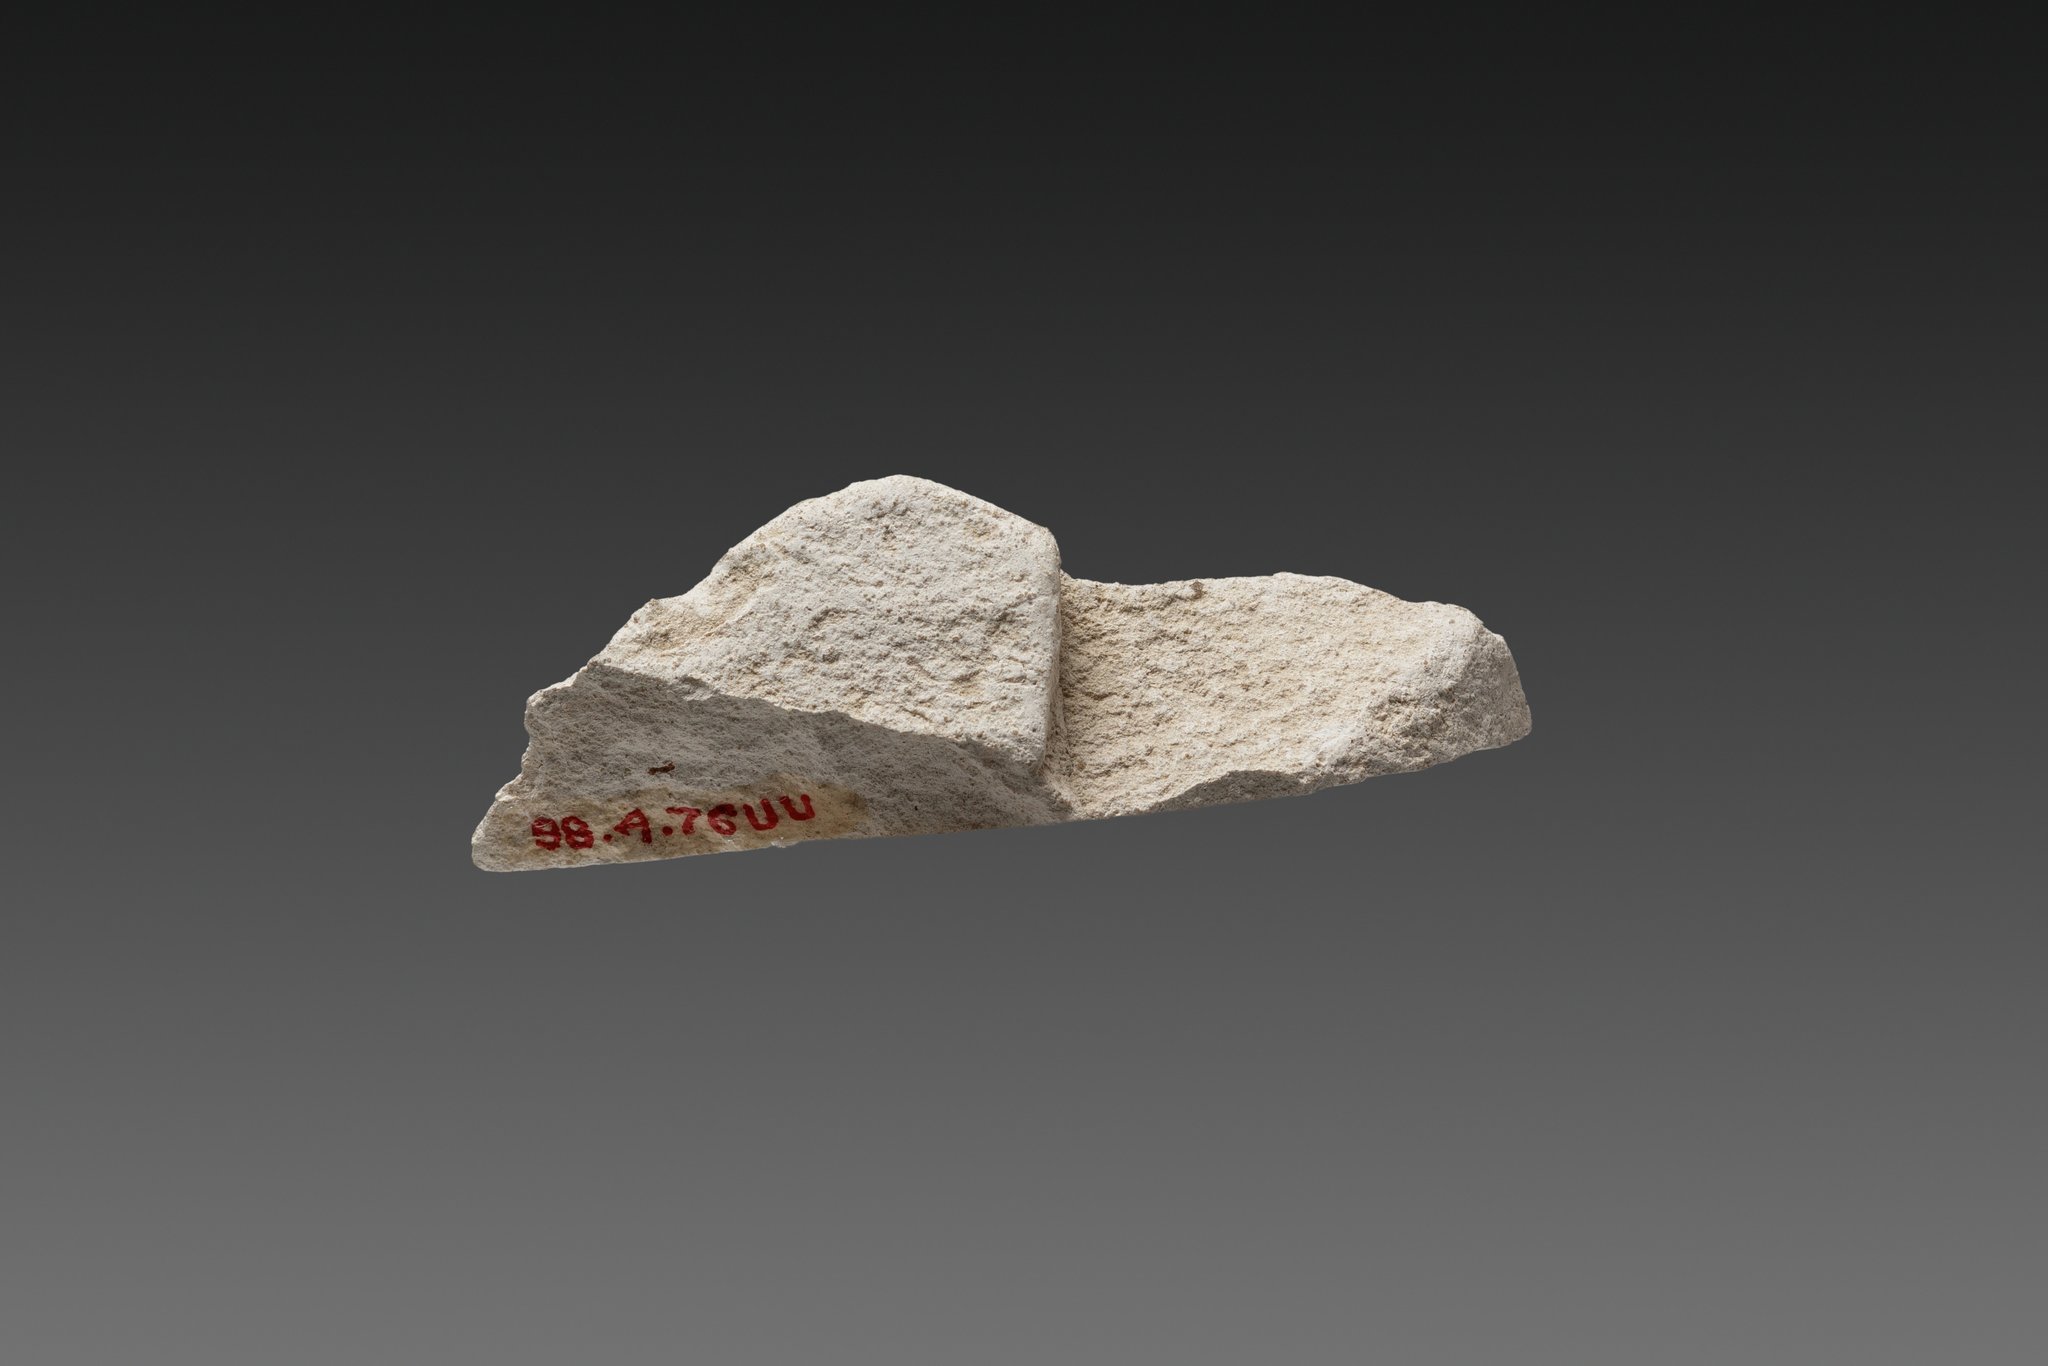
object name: relief fragment 47, tomb of mereri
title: Relief fragment possibly from the tomb of Mereri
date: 2100-2090 BCE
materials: limestone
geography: egypt